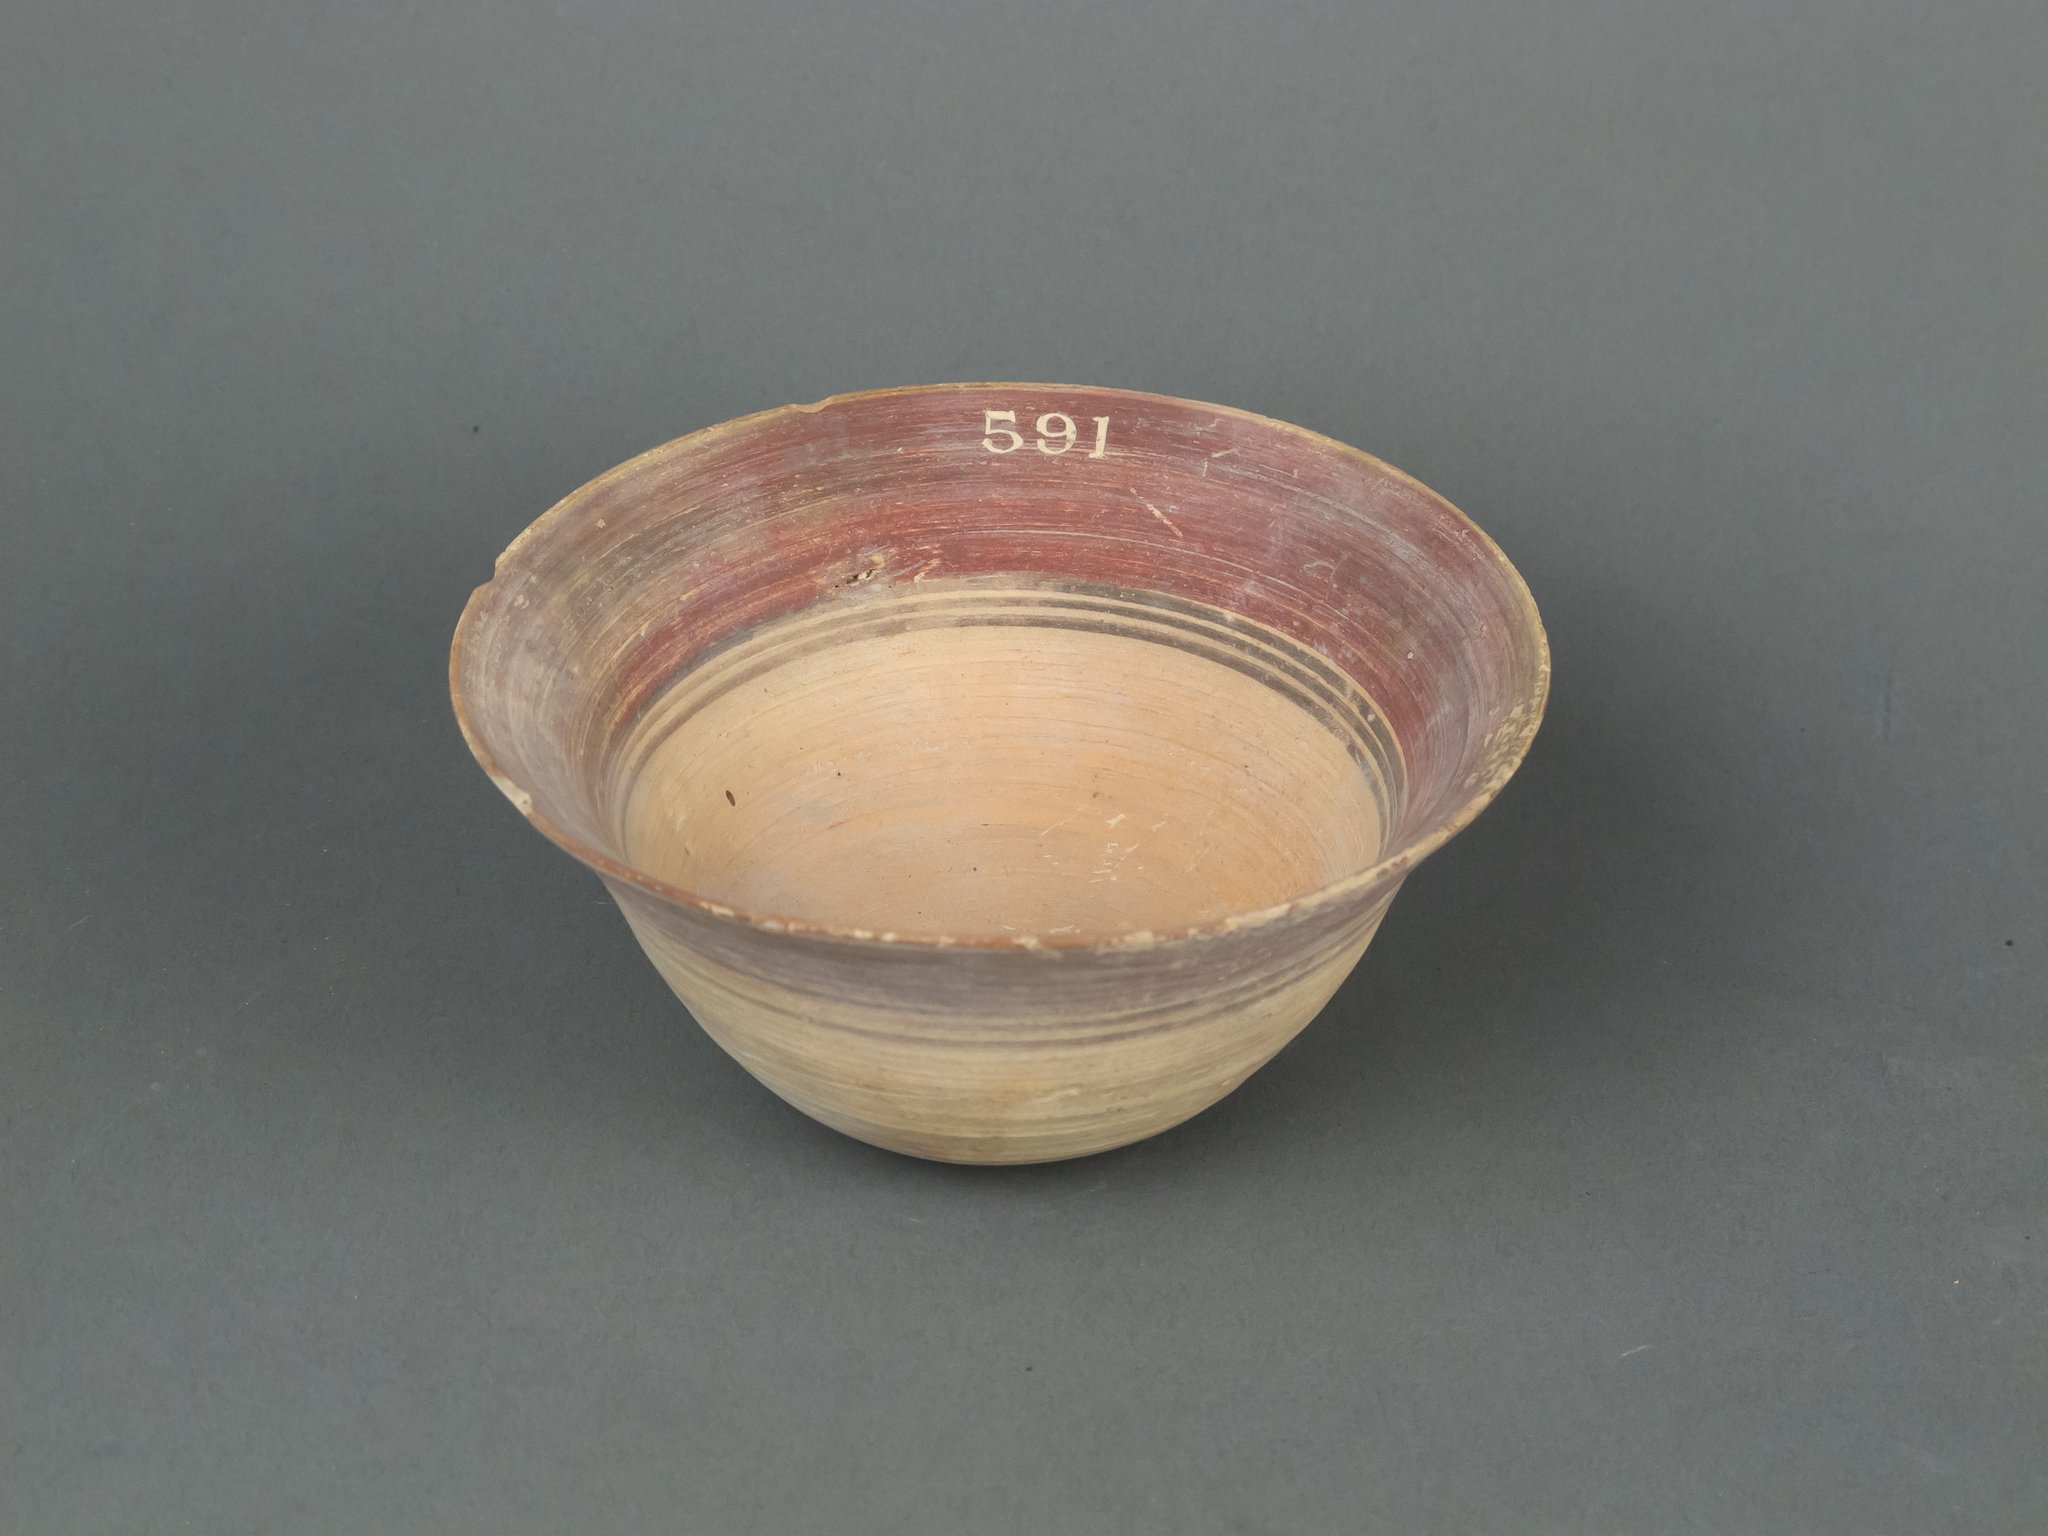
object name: bowl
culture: cypriot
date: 600-480 BCE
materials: terracotta